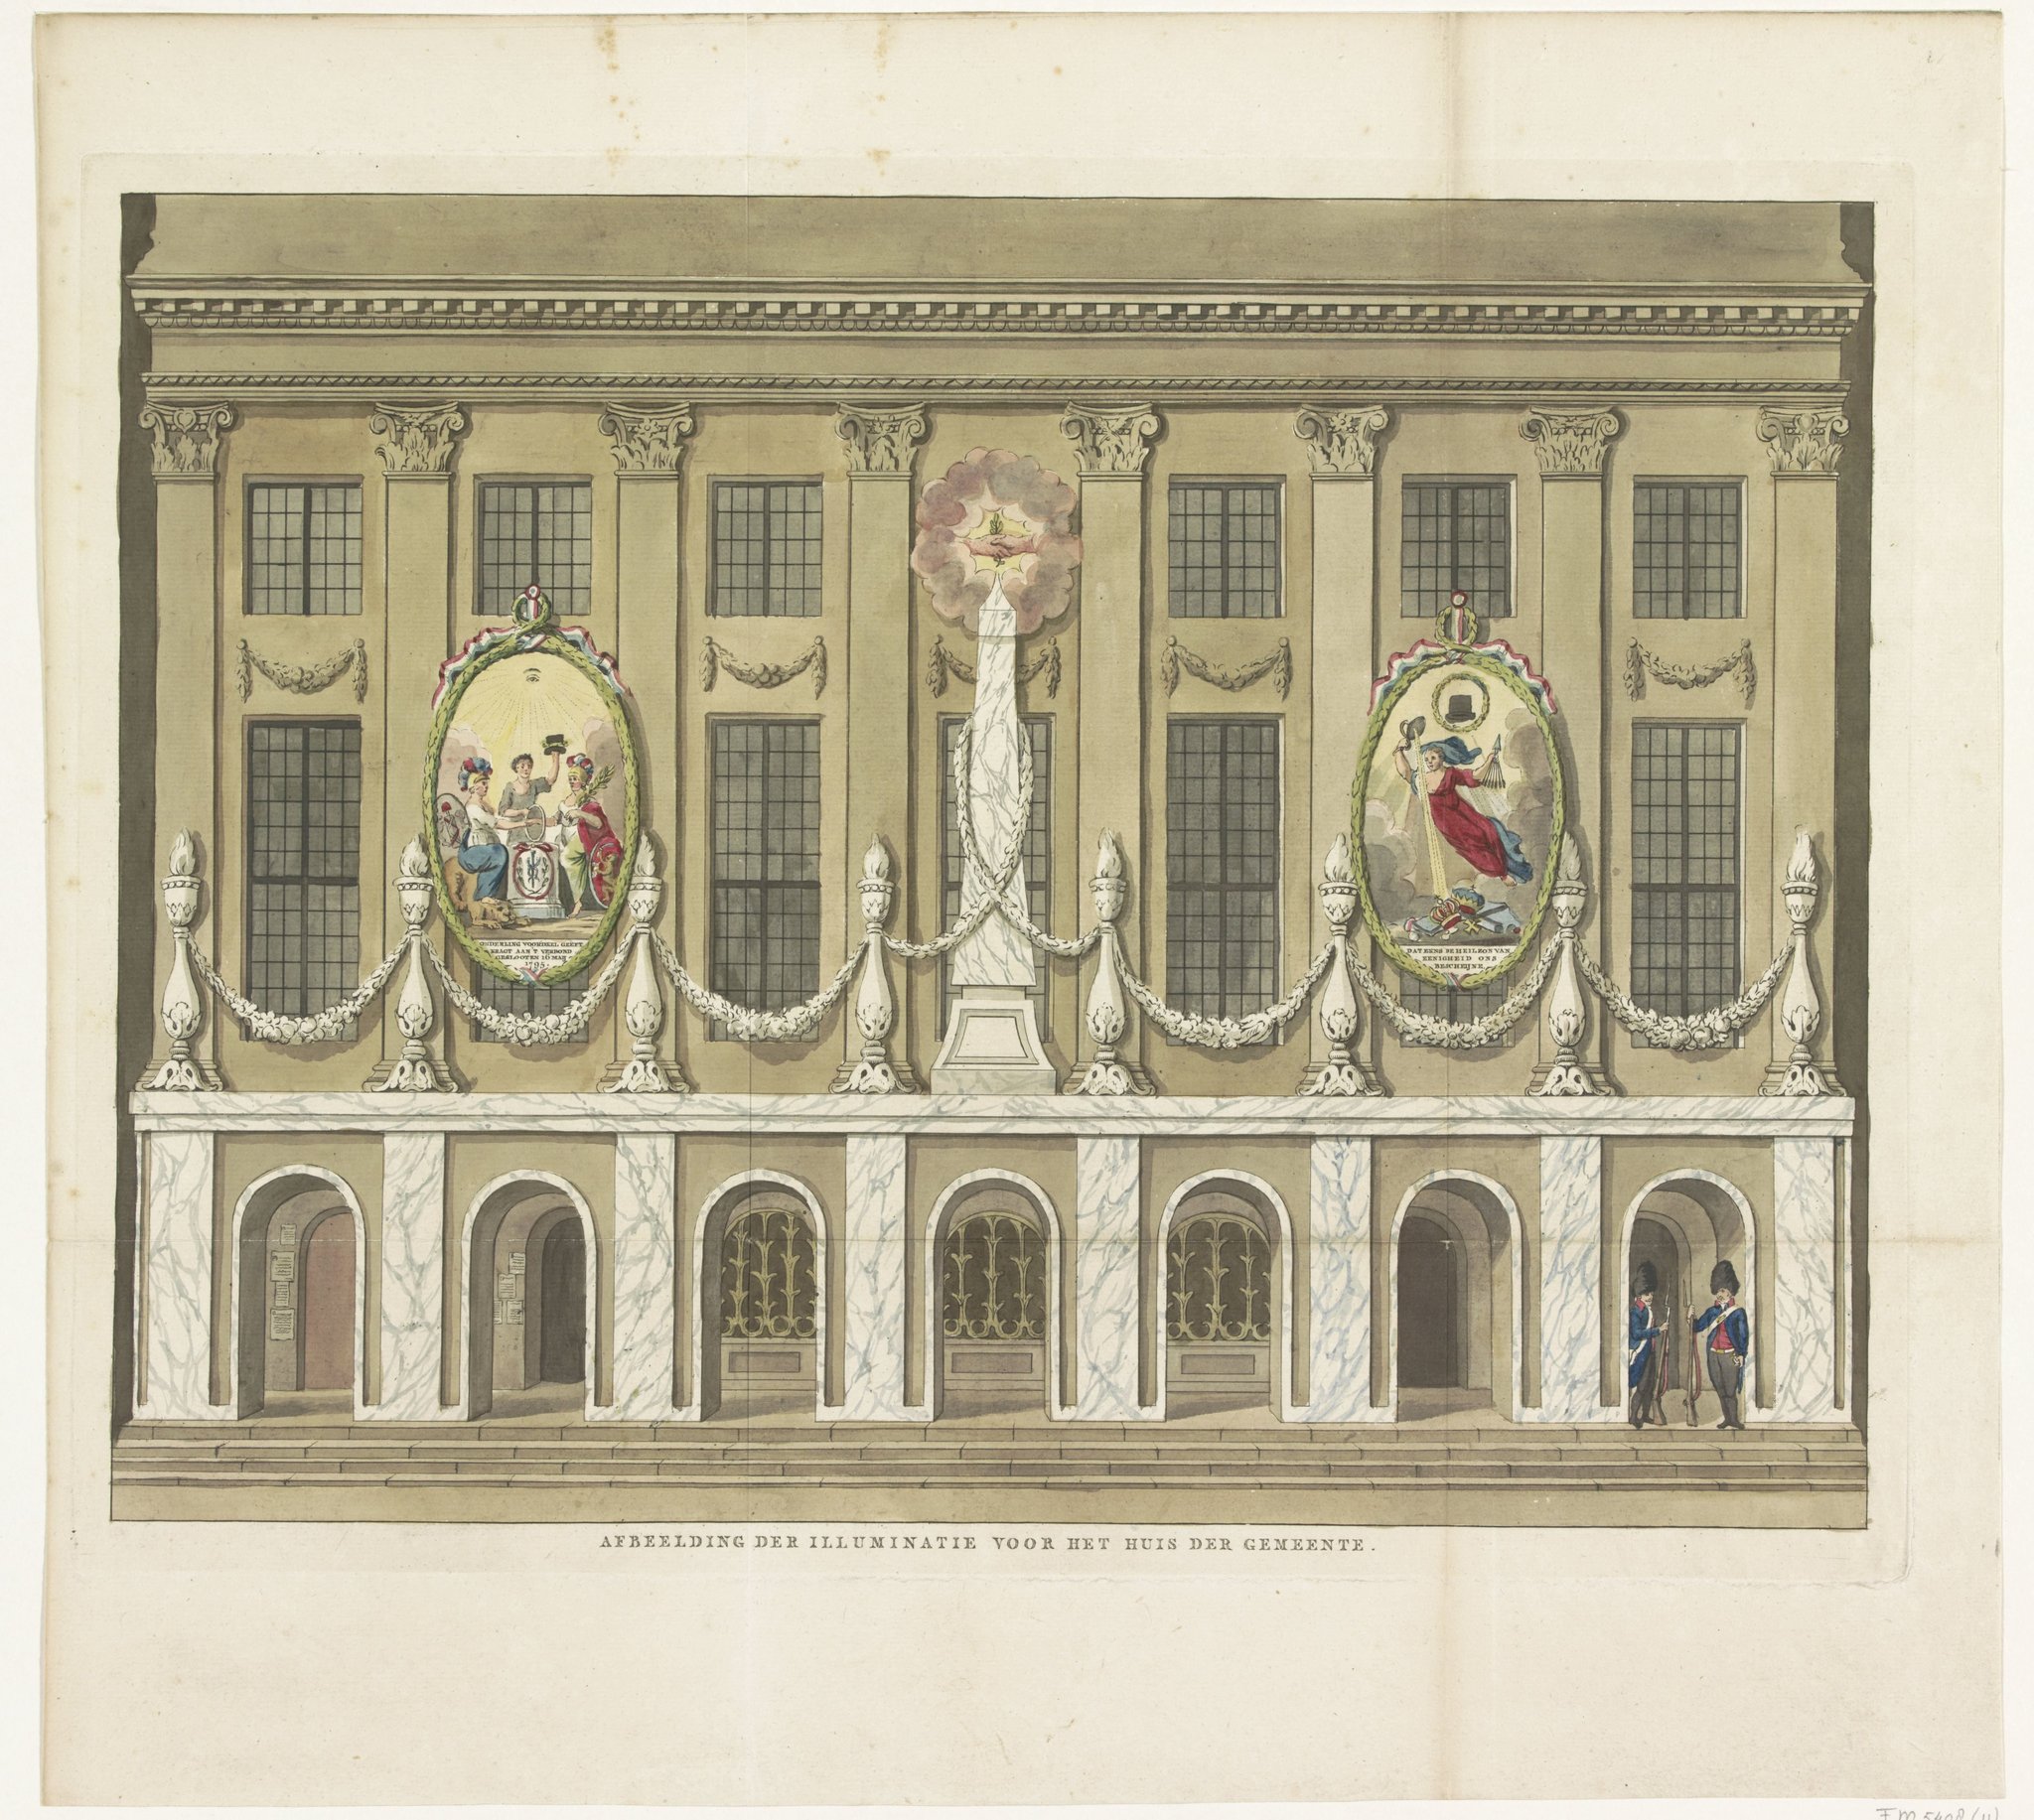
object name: print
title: Aanstaande Eenheid en Onverdeelbaarheid, van het Bataafse Gemenebest en de Alliantie, decoratie op het Stadhuis op de Dam, 1795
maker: Anonymous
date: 1795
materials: paper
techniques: etching, hand coloring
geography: netherlands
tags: festivities on events of national importance (+ festive decoration ~ festive activities), amsterdam, alliance with france (1795)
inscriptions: collector's mark: Lugt 2760, collector's mark: Lugt 2228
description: De Alliantie gesloten tussen de Franse en de Bataafse Republiek op 16 mei 1795 en de Aanstaande Eenheid en Onverdeelbaarheid van het Bataafse Gemenebest. Twee allegorische decoraties op de gevel van het Stadhuis op de Dam te Amsterdam bij het Alliantiefeest op 19 juni 1795.